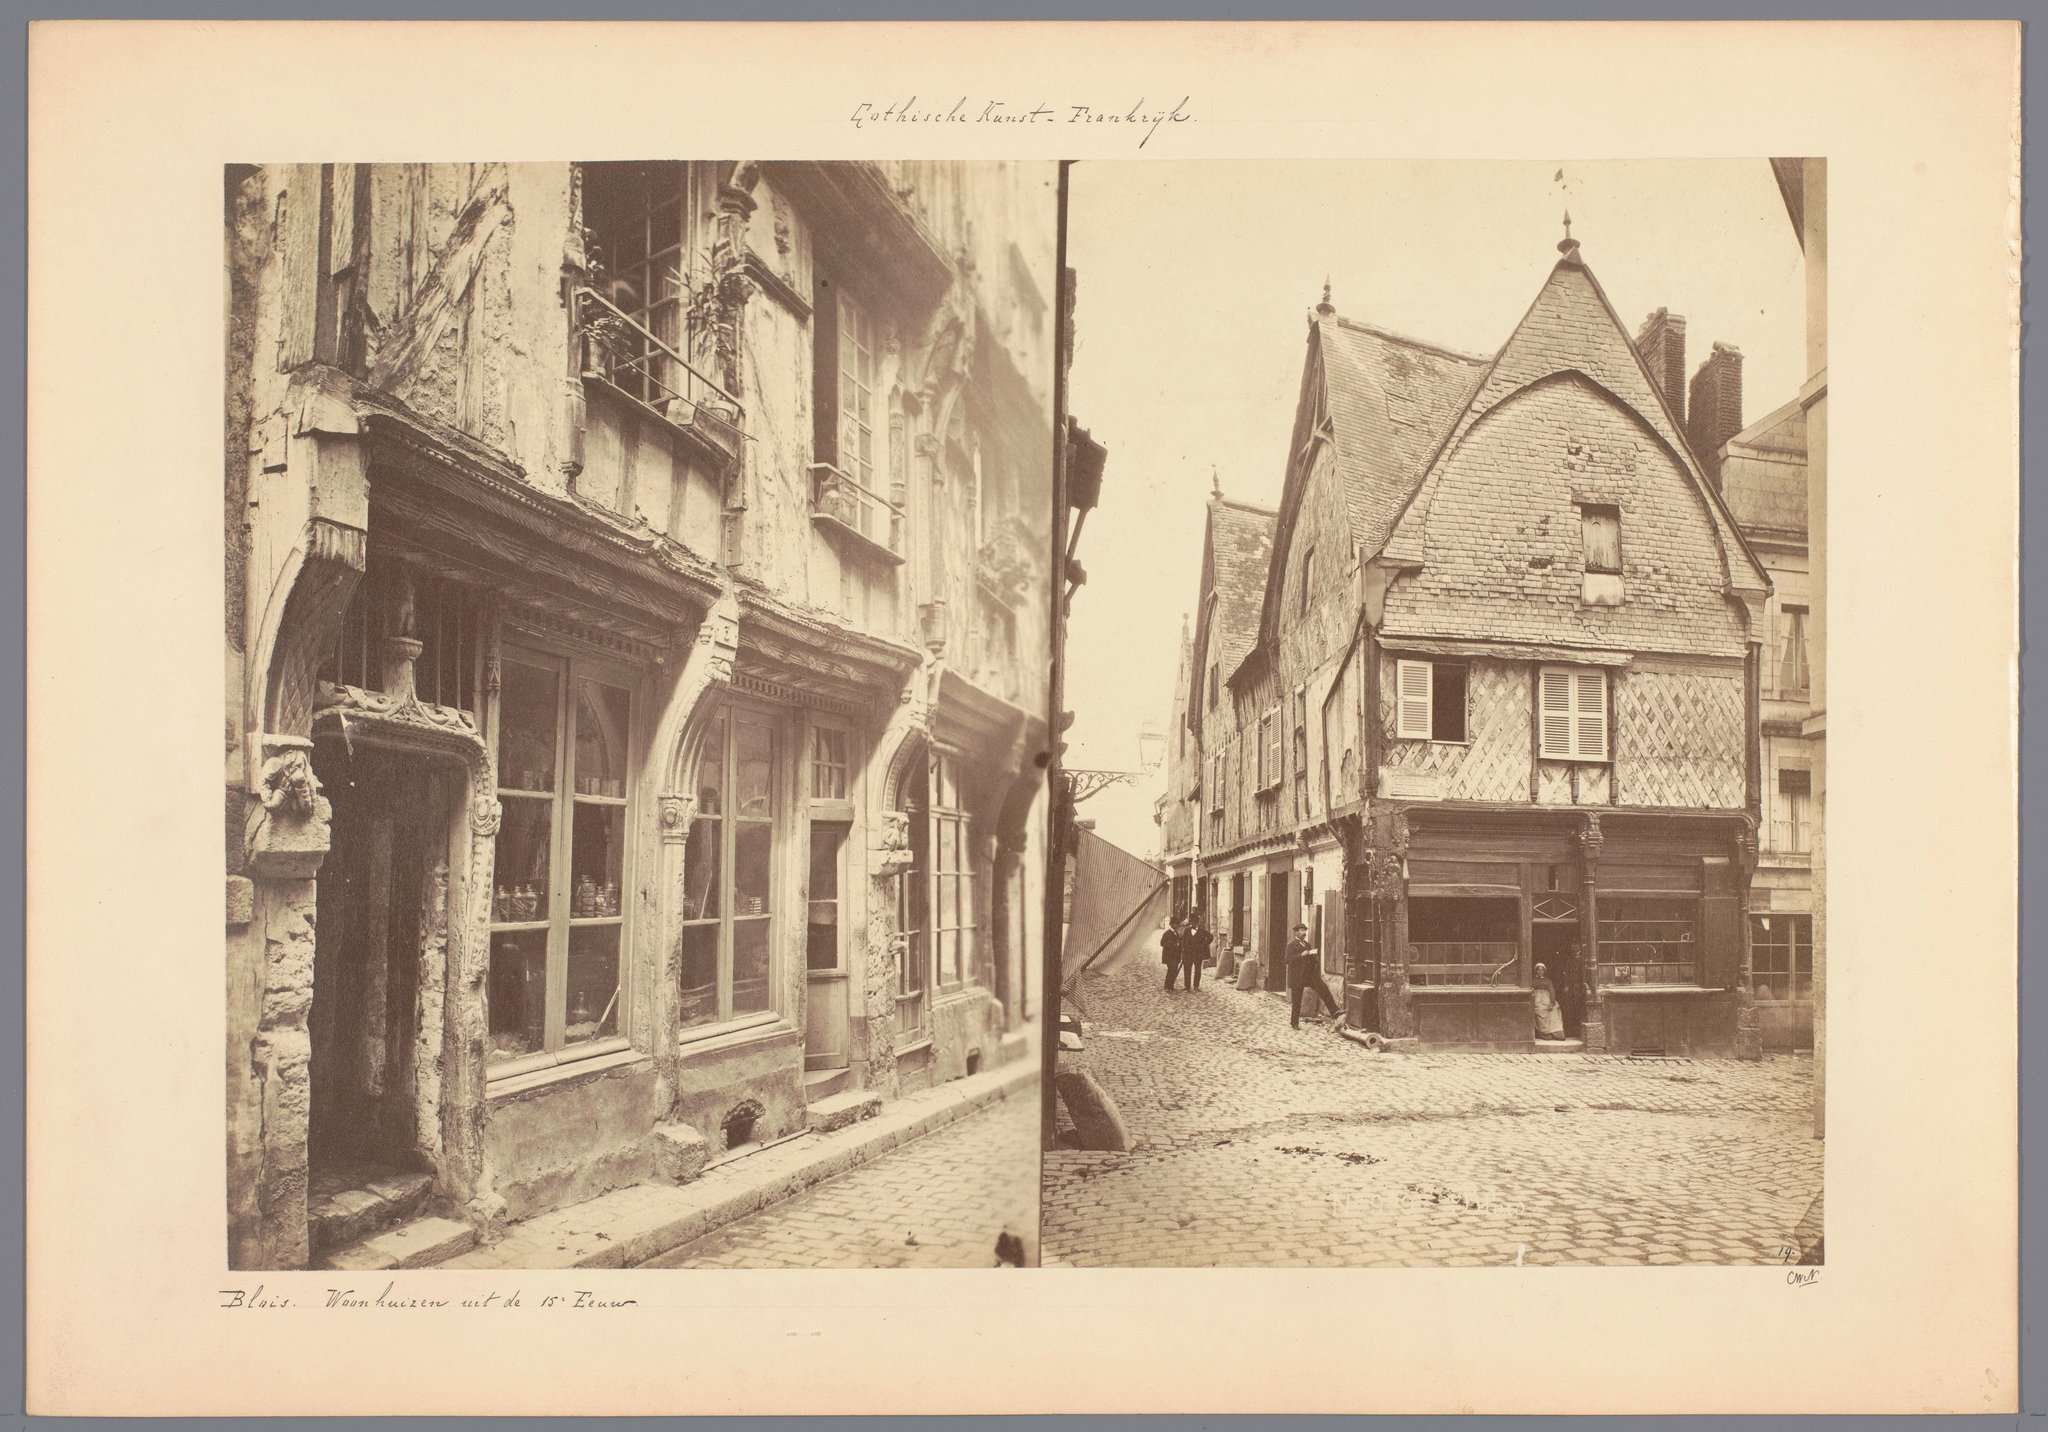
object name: photograph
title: Twee gezichten op woonhuizen te Blois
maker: séraphin-médéric mieusement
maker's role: fotograaf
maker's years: 1840-1905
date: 1875-1900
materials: cardboard, photographic support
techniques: albumen print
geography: blois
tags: housing, façade (of house or building), street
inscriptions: number: ‘No 929’, number: ‘19.’, inscription: ‘CWN.’, name: ‘MIEUSEMENT PHOTOGRAPHE’, collector's mark: ‘INSTITUUT VOOR KUNST- NIJVERHEIDSONDERWIJS GABRIËL METSUSTRAAT No. 16. AMSTERDAM’, inscription: ‘Gothische Kunst - Frankrijk. Blois. Woonhuizen uit de 15e Eeuw.’, collector's mark: ‘KUNSTNIJVERHEIDSCHOOL QUELLINUS AMSTERDAM FRANS HALSSTRAAT 14.’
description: Links een rijtjeshuis, rechts een hoekhuis aan een plein.